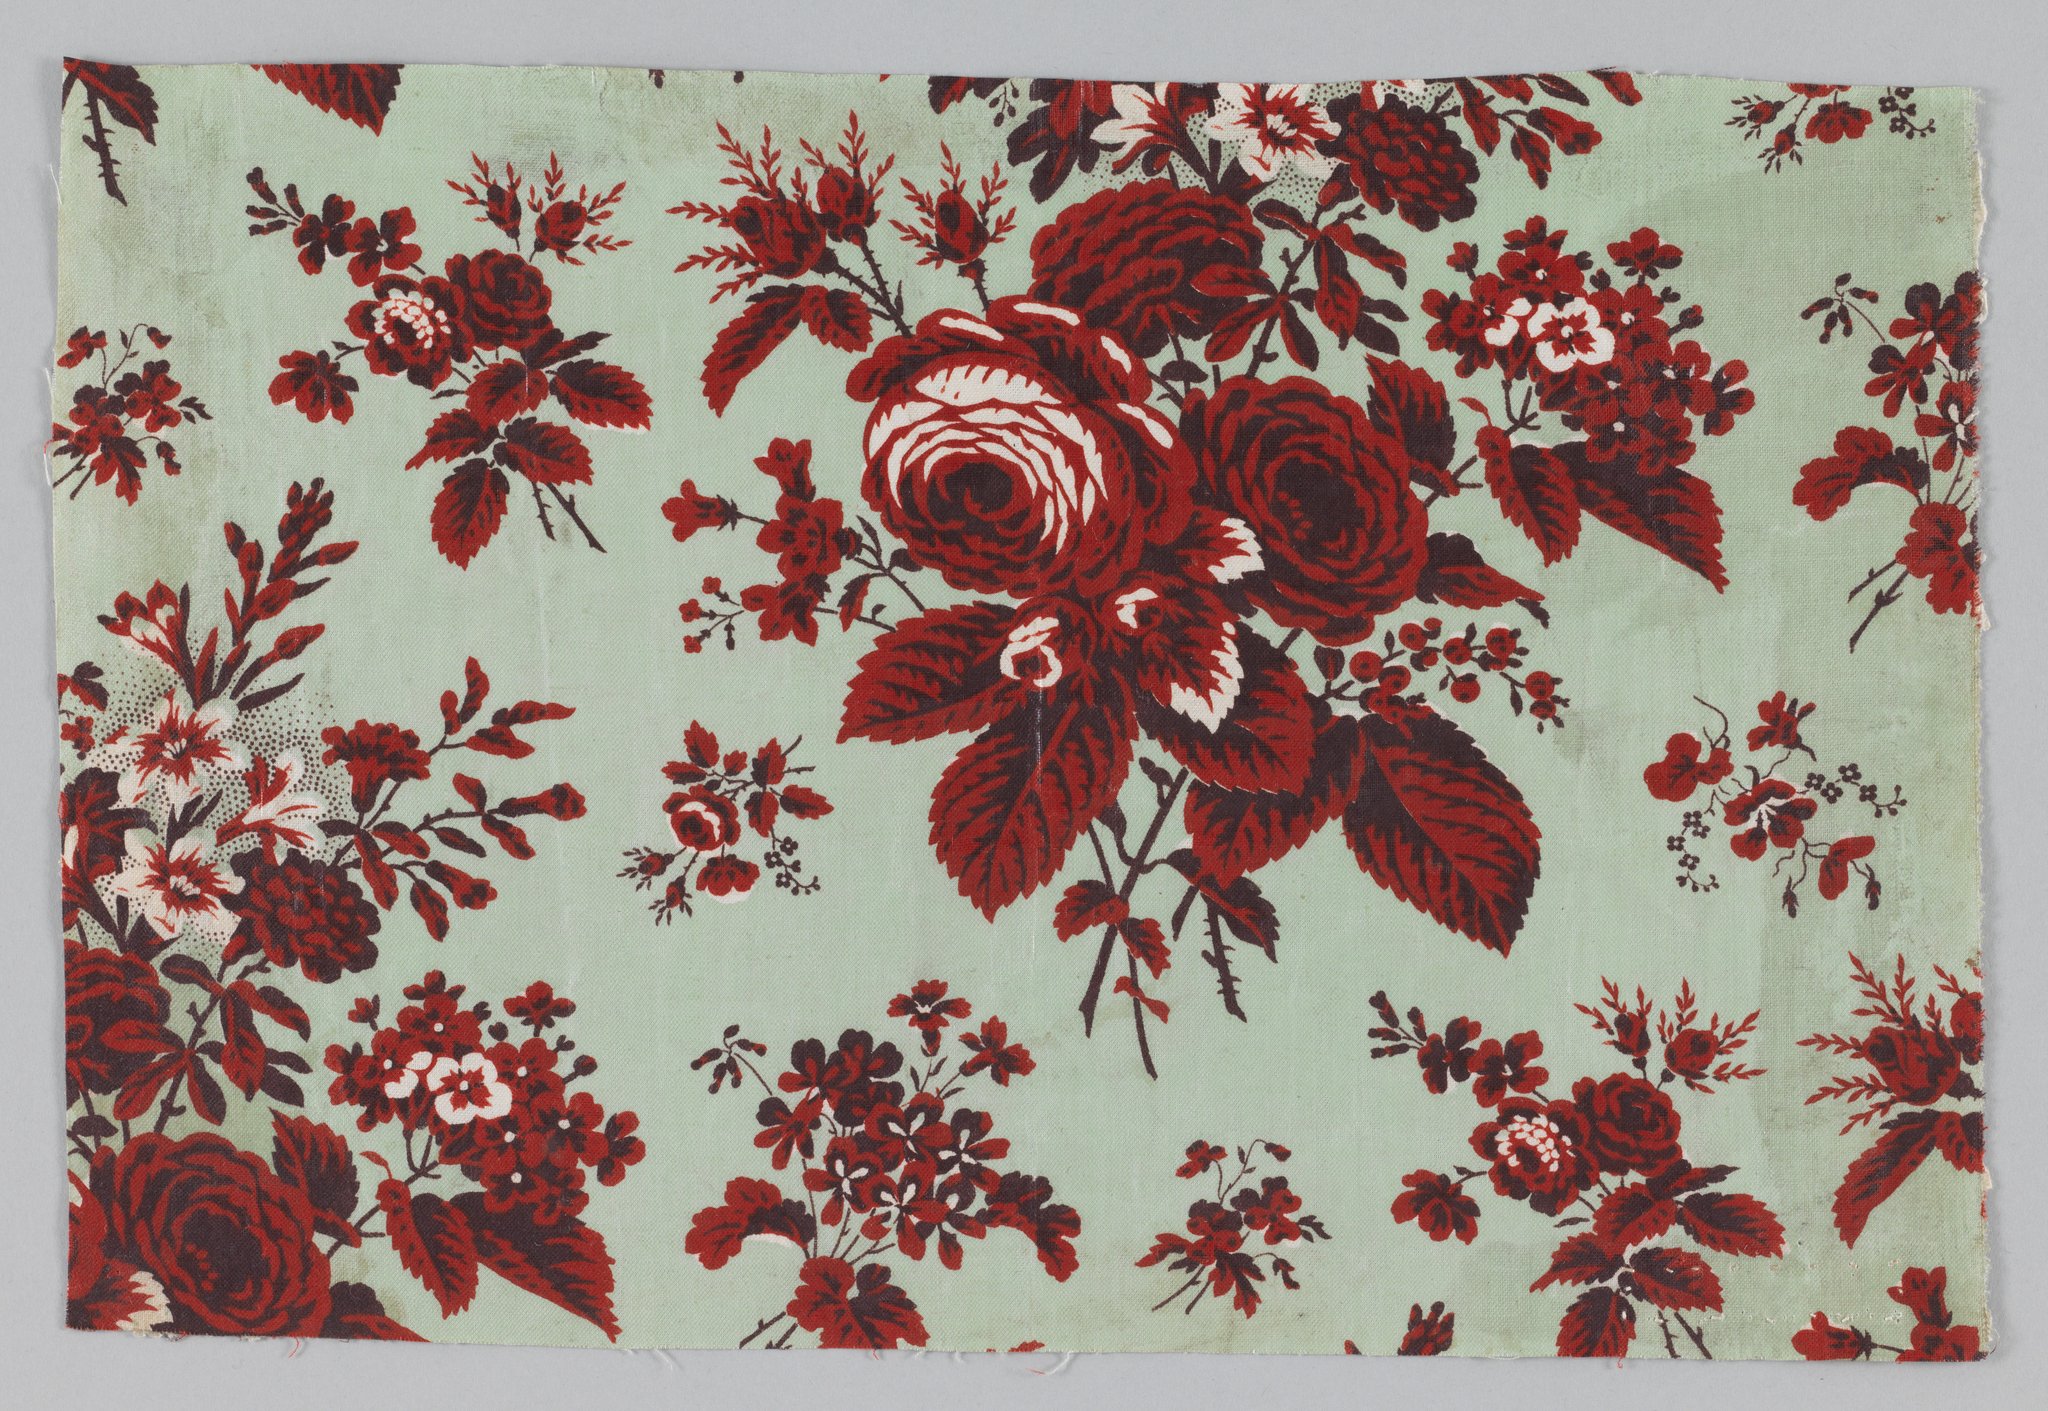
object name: piece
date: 1801-1900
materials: cotton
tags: flowers